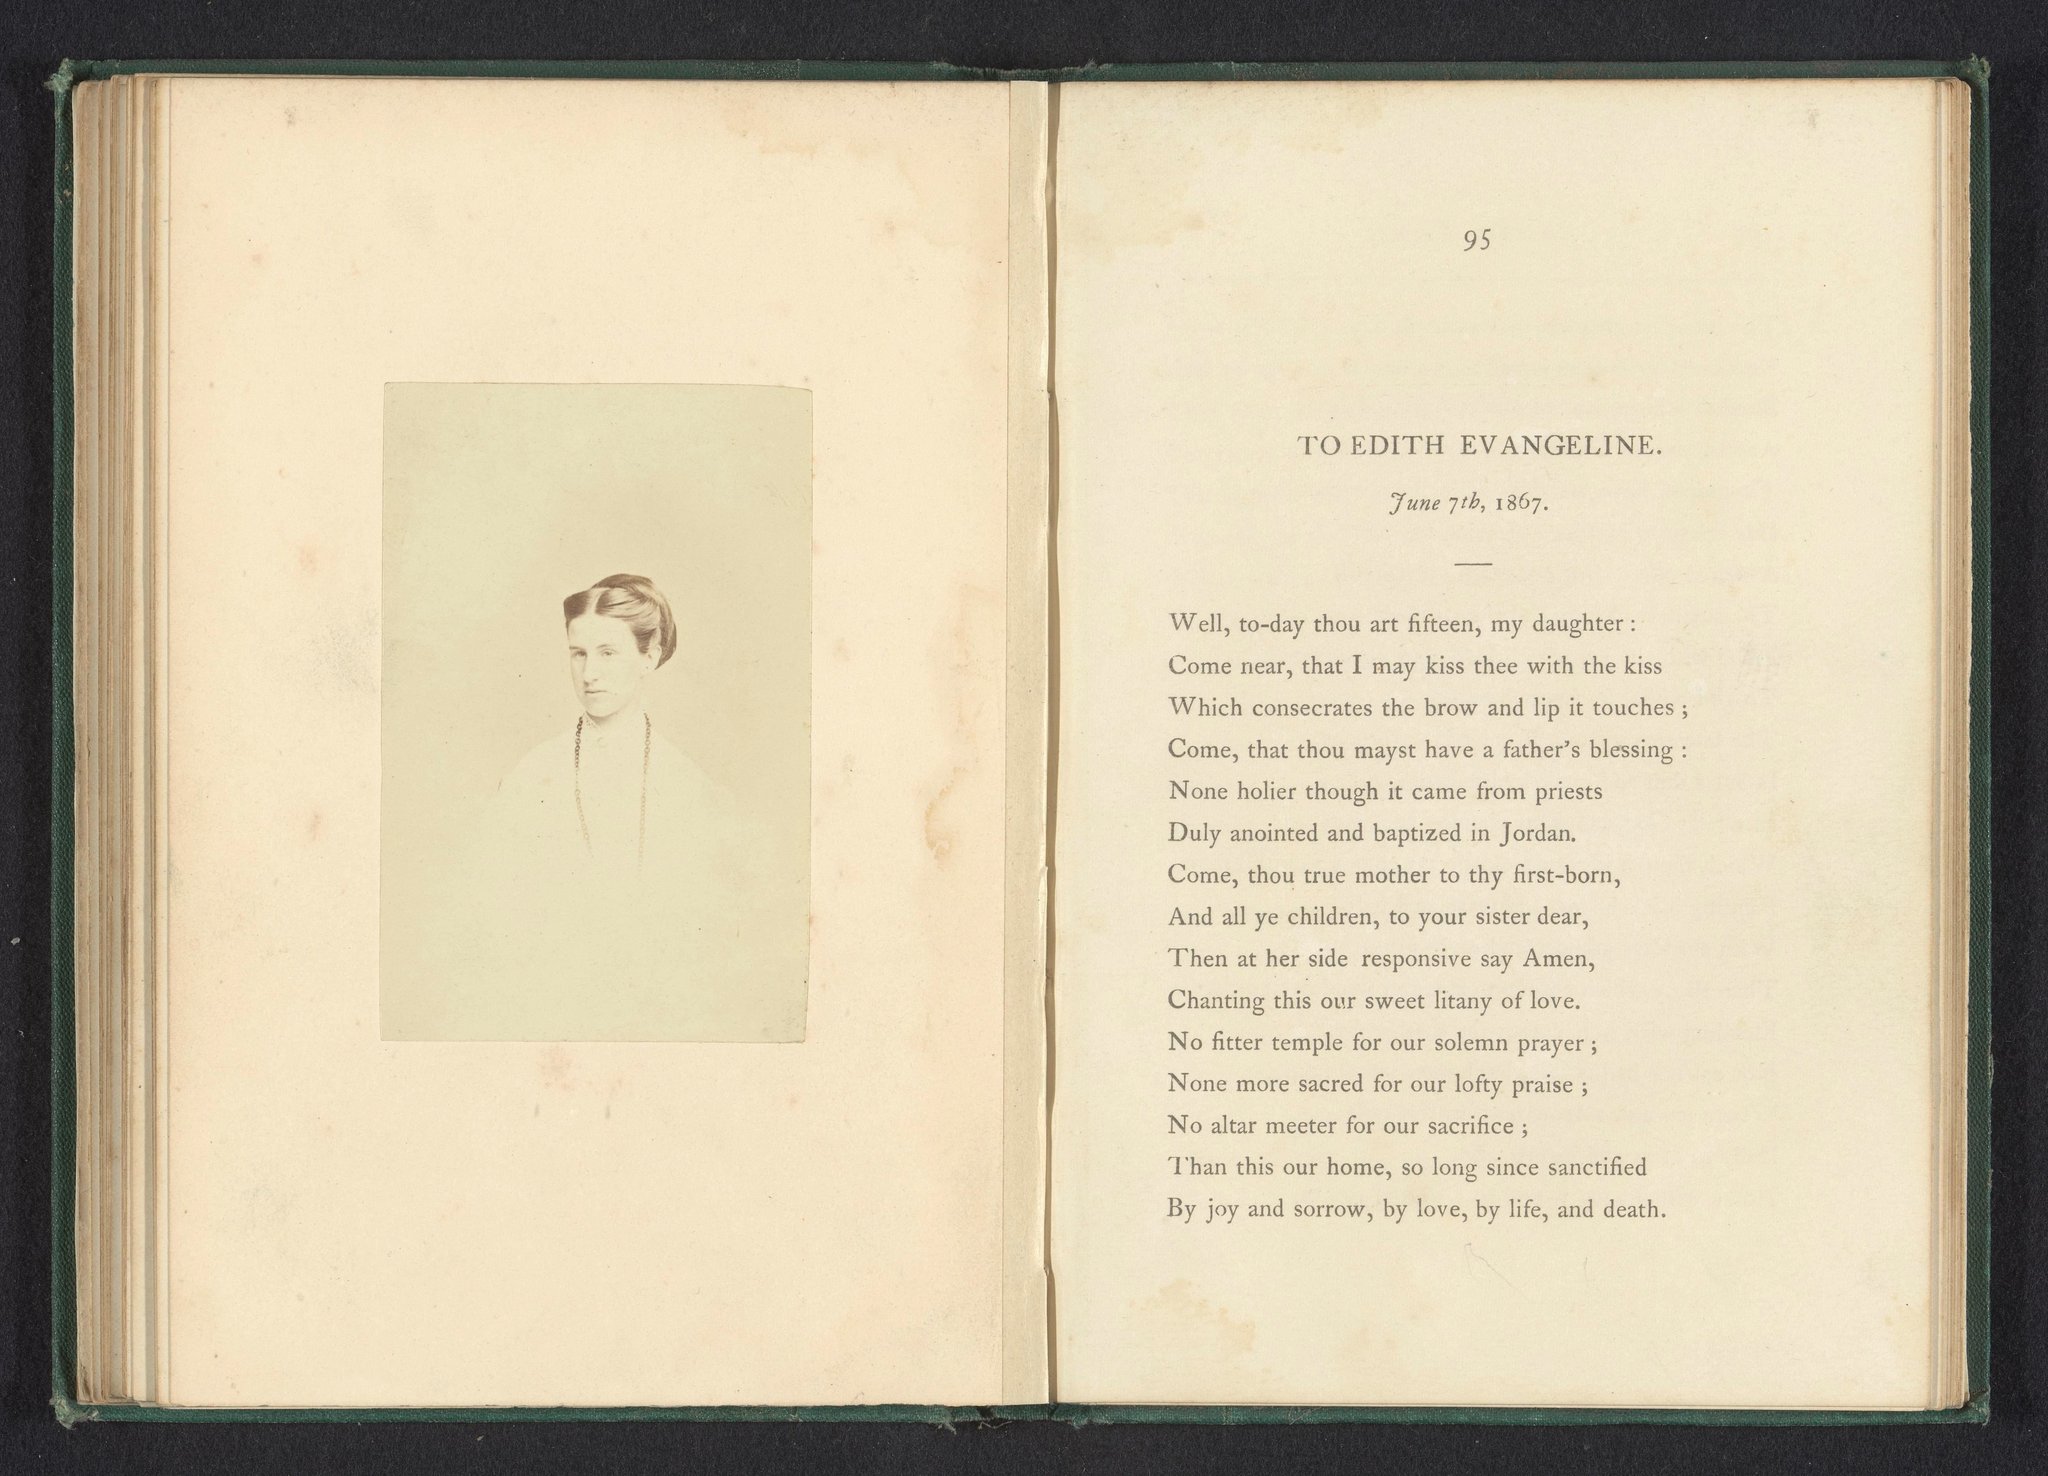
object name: page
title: Portret van Edith Evangeline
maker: Anonymous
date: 1863-1868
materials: photographic support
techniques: albumen print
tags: adolescent, young woman, maiden